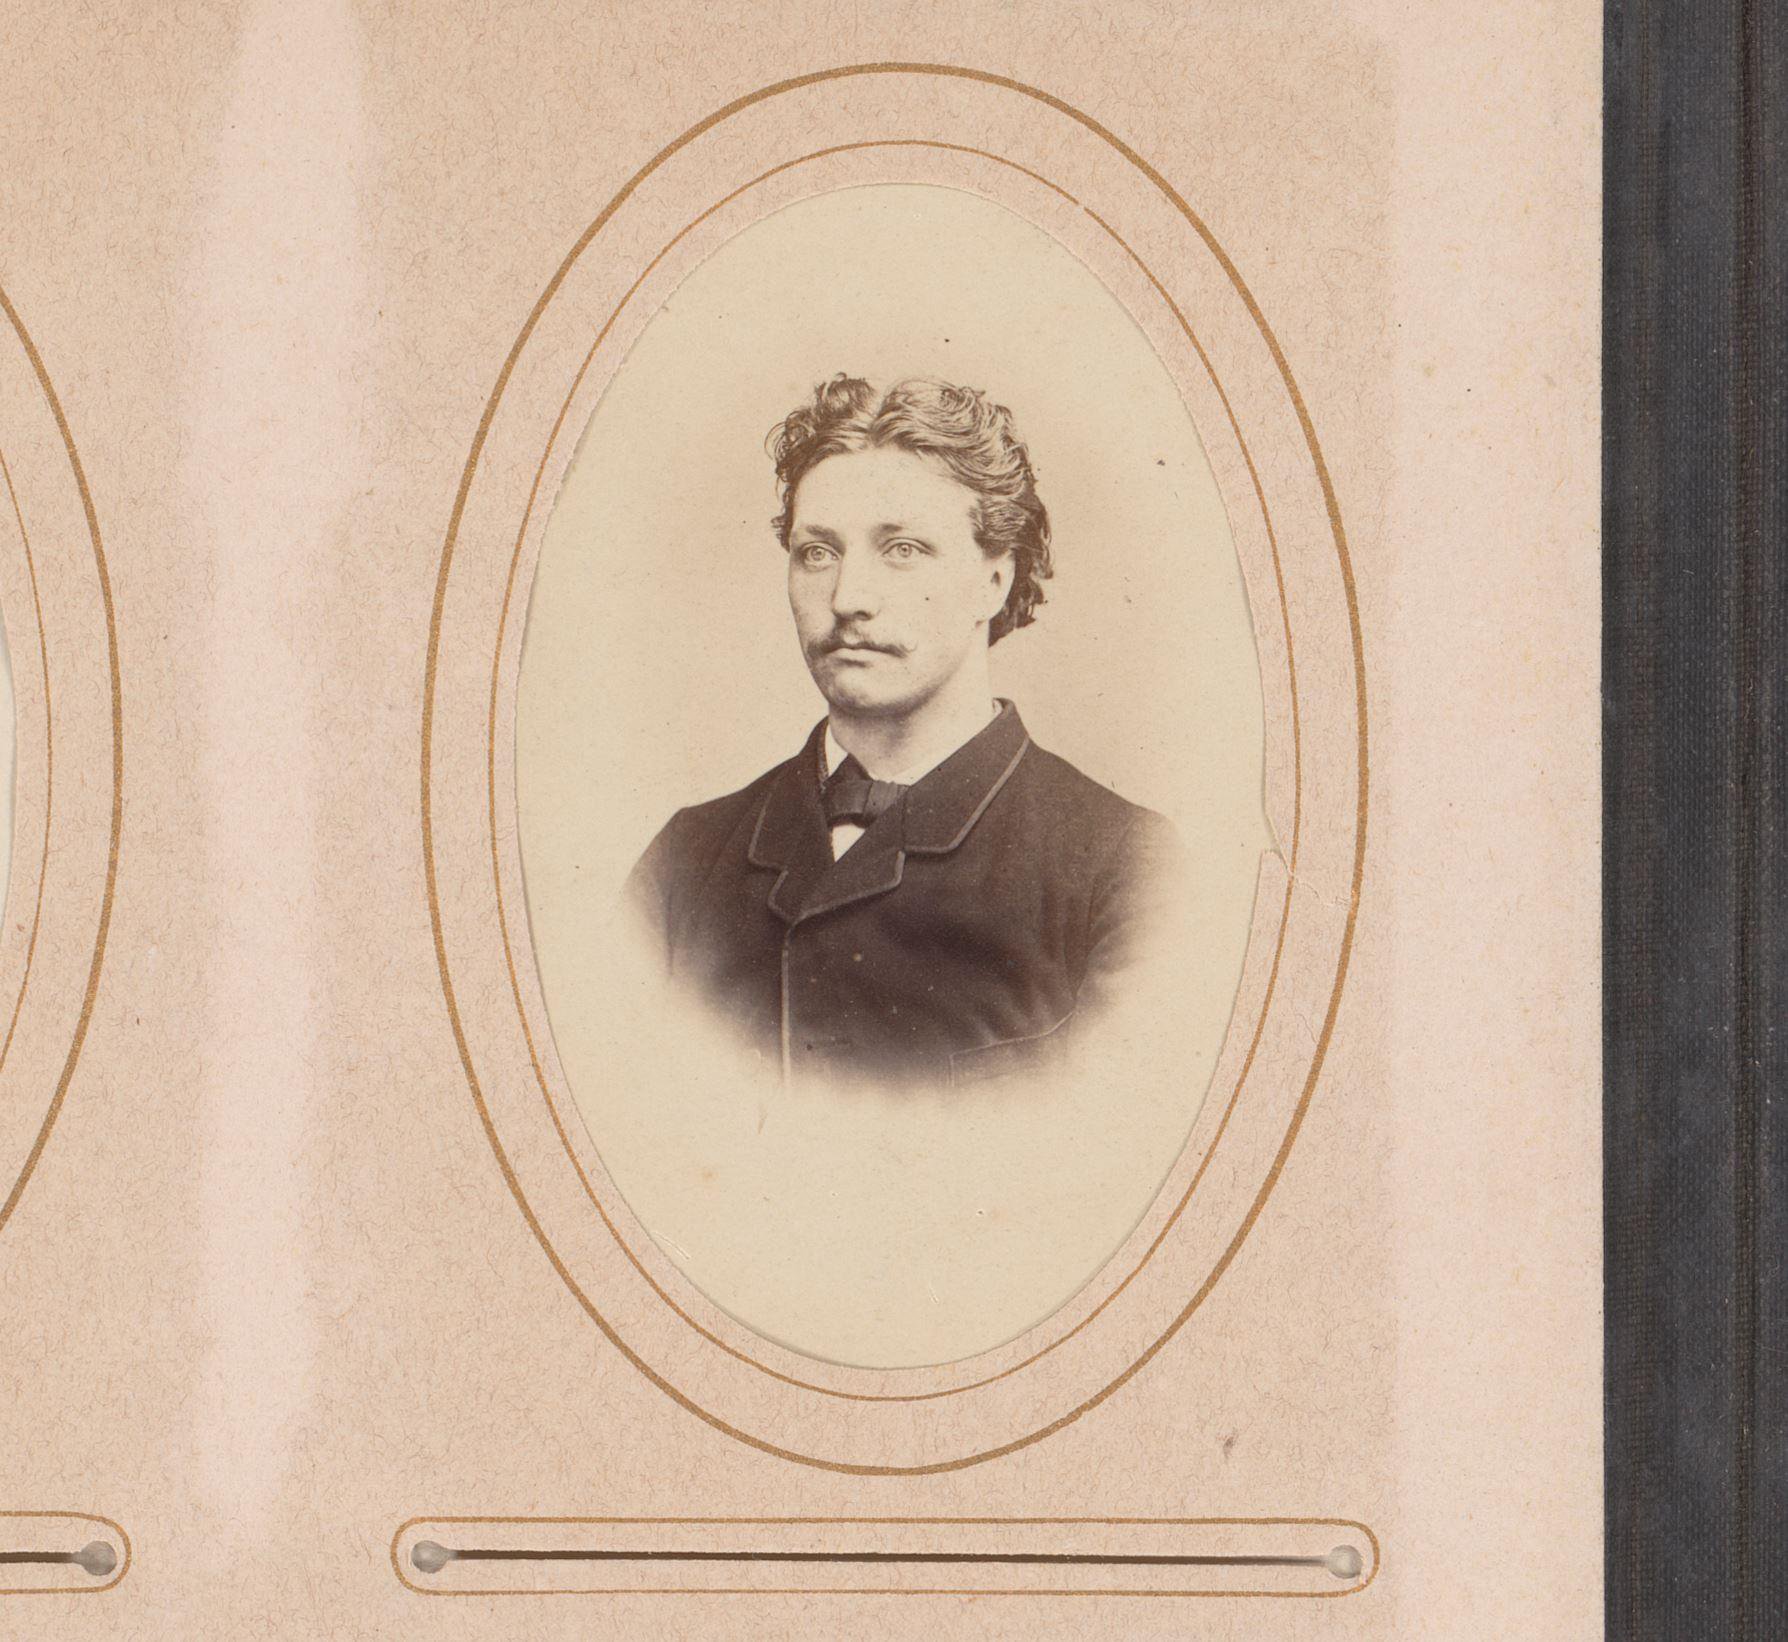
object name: carte de visite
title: Portret van een man met snor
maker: johannes frederik hulk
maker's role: draughtsman, painter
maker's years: 1829-1911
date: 1860-1890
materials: cardboard, photographic support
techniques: albumen print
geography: amsterdam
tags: moustache, historical persons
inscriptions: inscription: ‘Atelier Rembrandt/ H/ J.F. Hulk/ Amsterdam/ Rokin E 167’